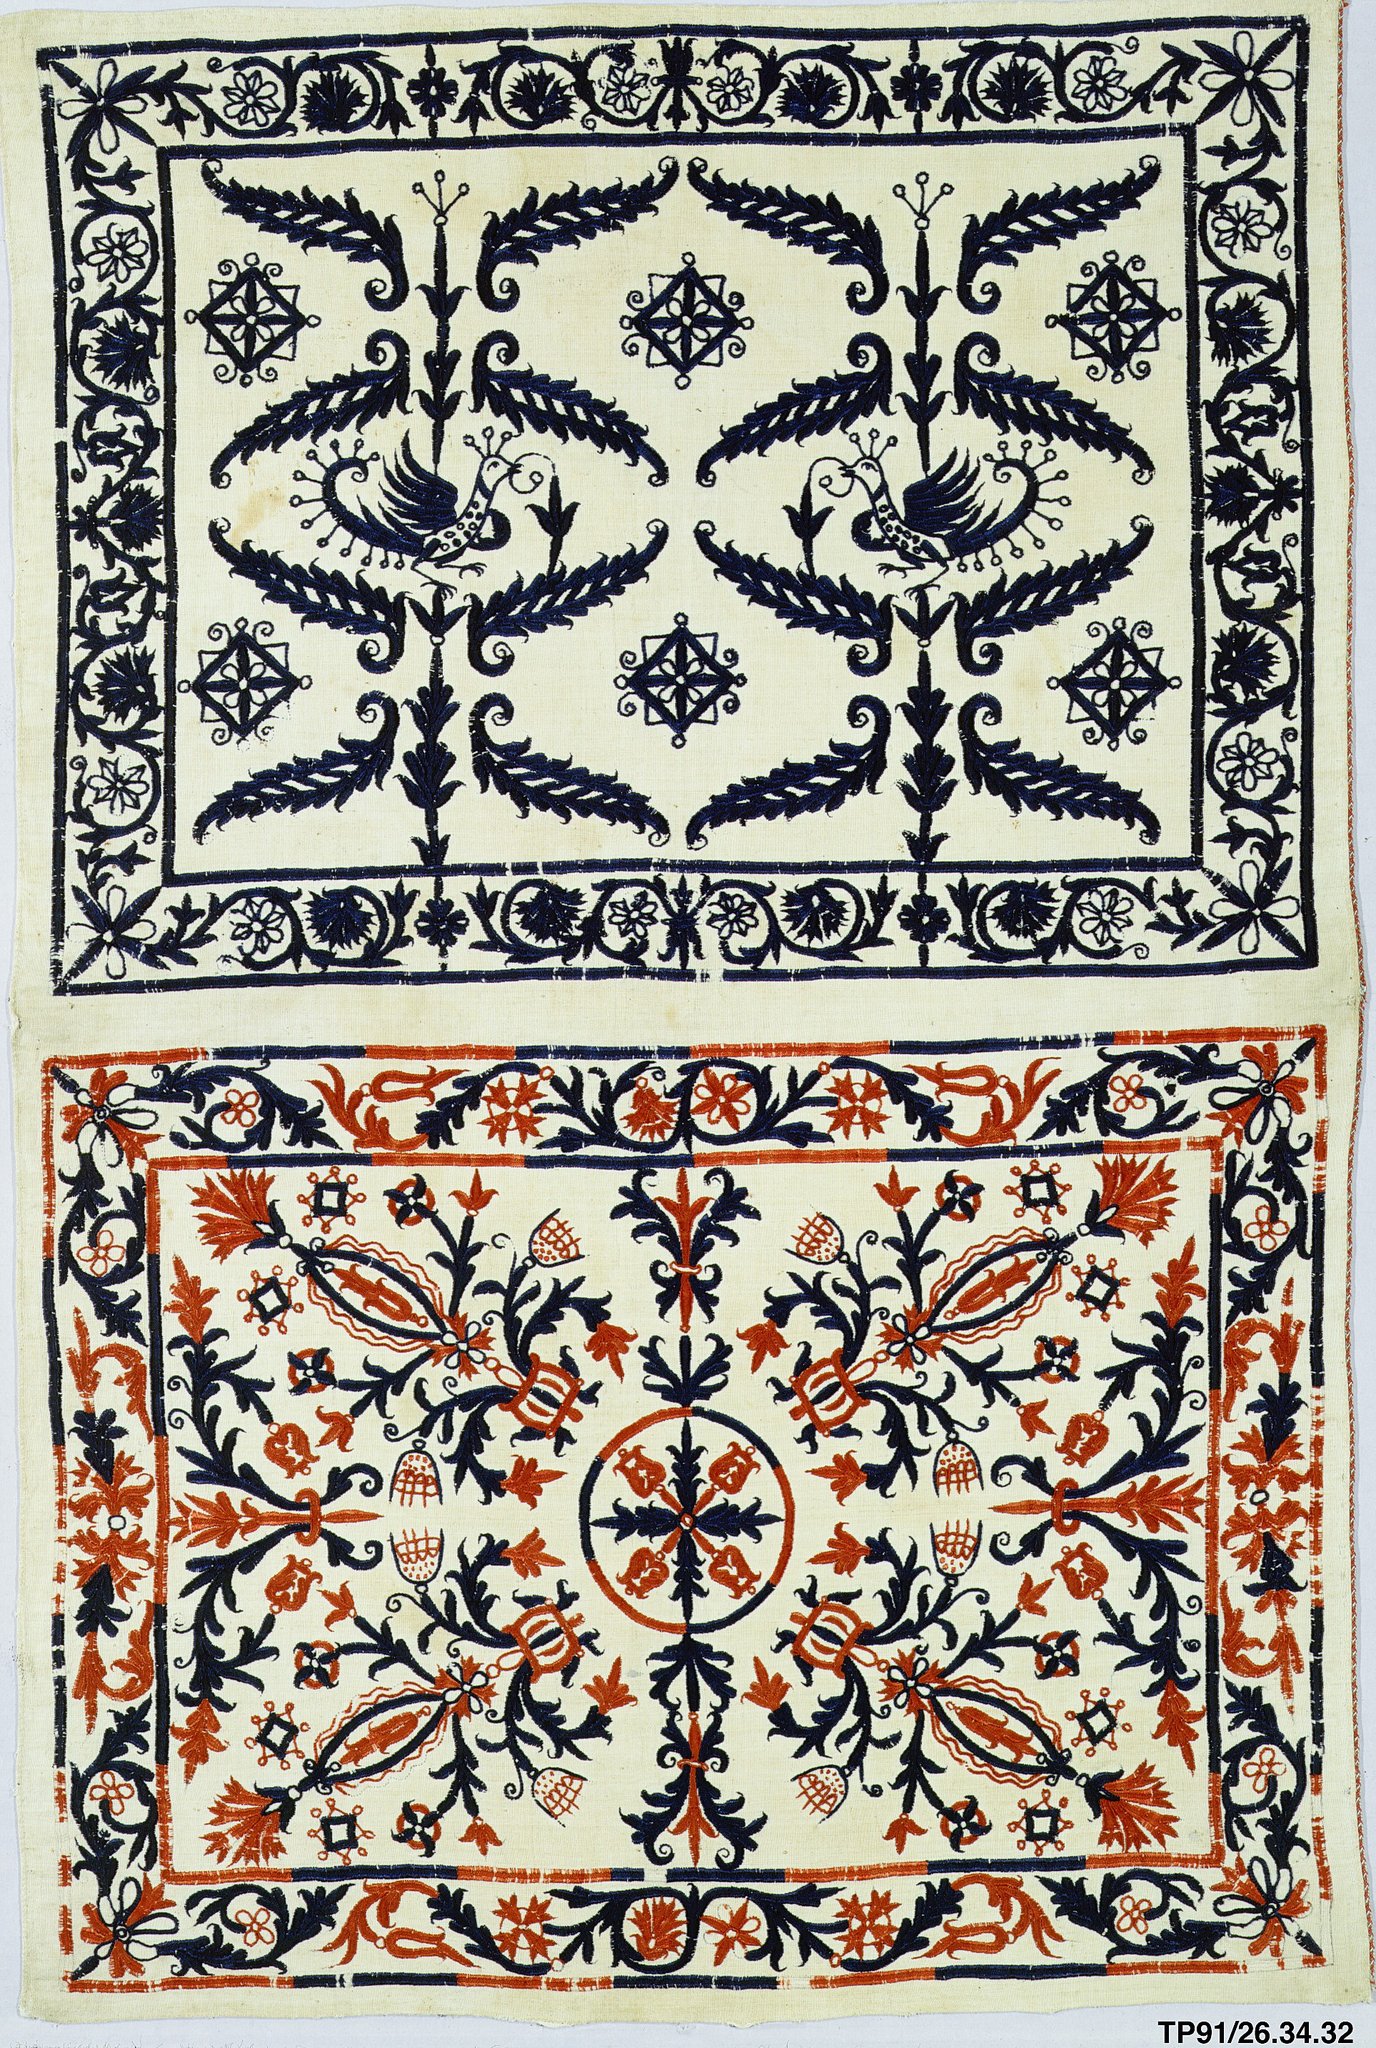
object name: pillowcase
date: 1701-1800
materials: linen, silk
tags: birds,flowers